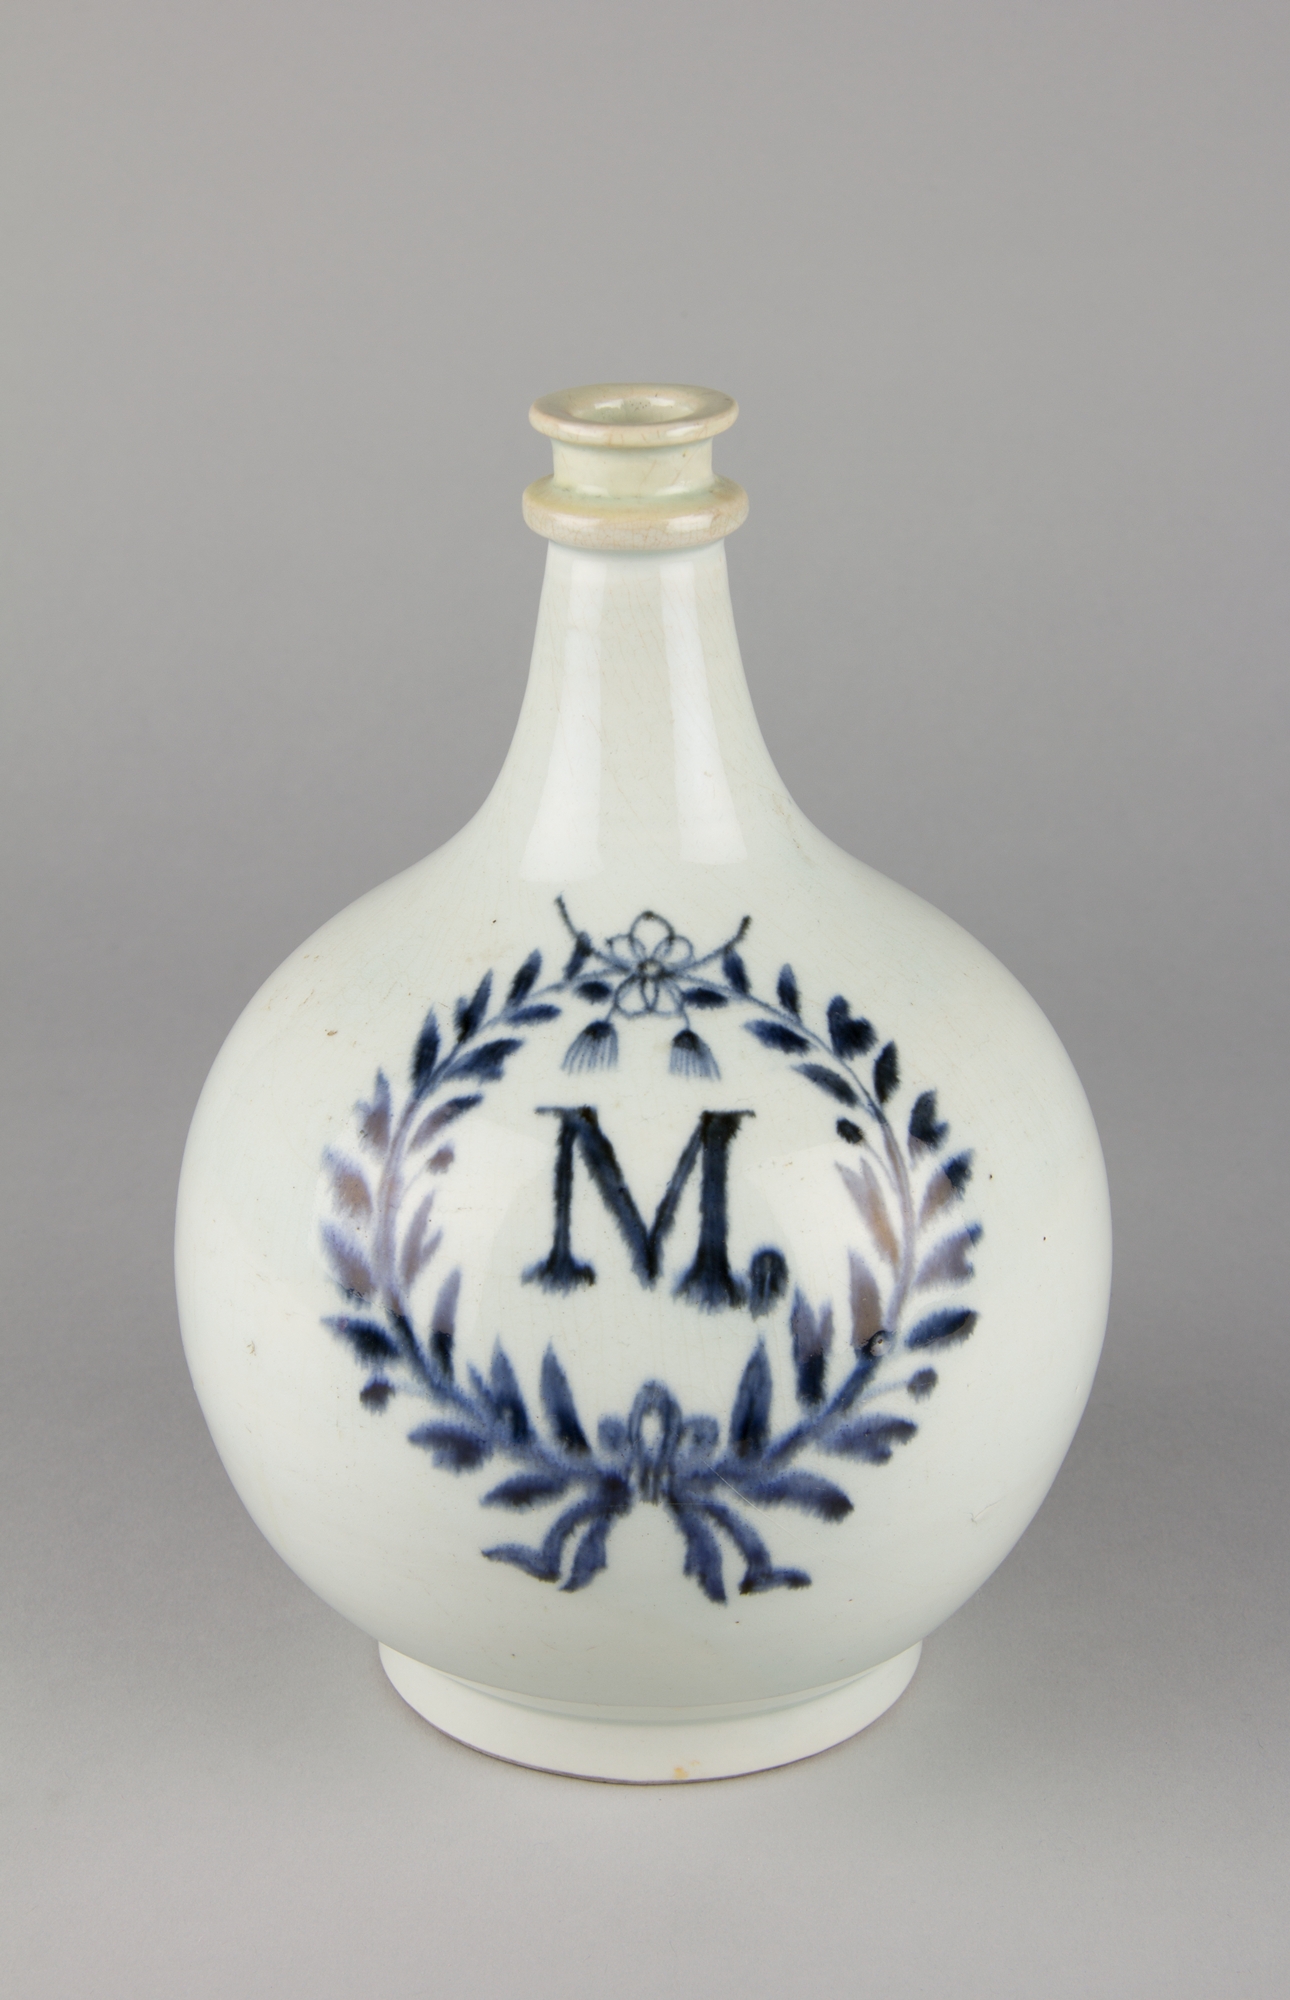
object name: apothecary bottle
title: Apothecary Bottle with Initial "M" in Laurel Wreath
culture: japanese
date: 1651-1700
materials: cobalt, glaze, porcelain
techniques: painting